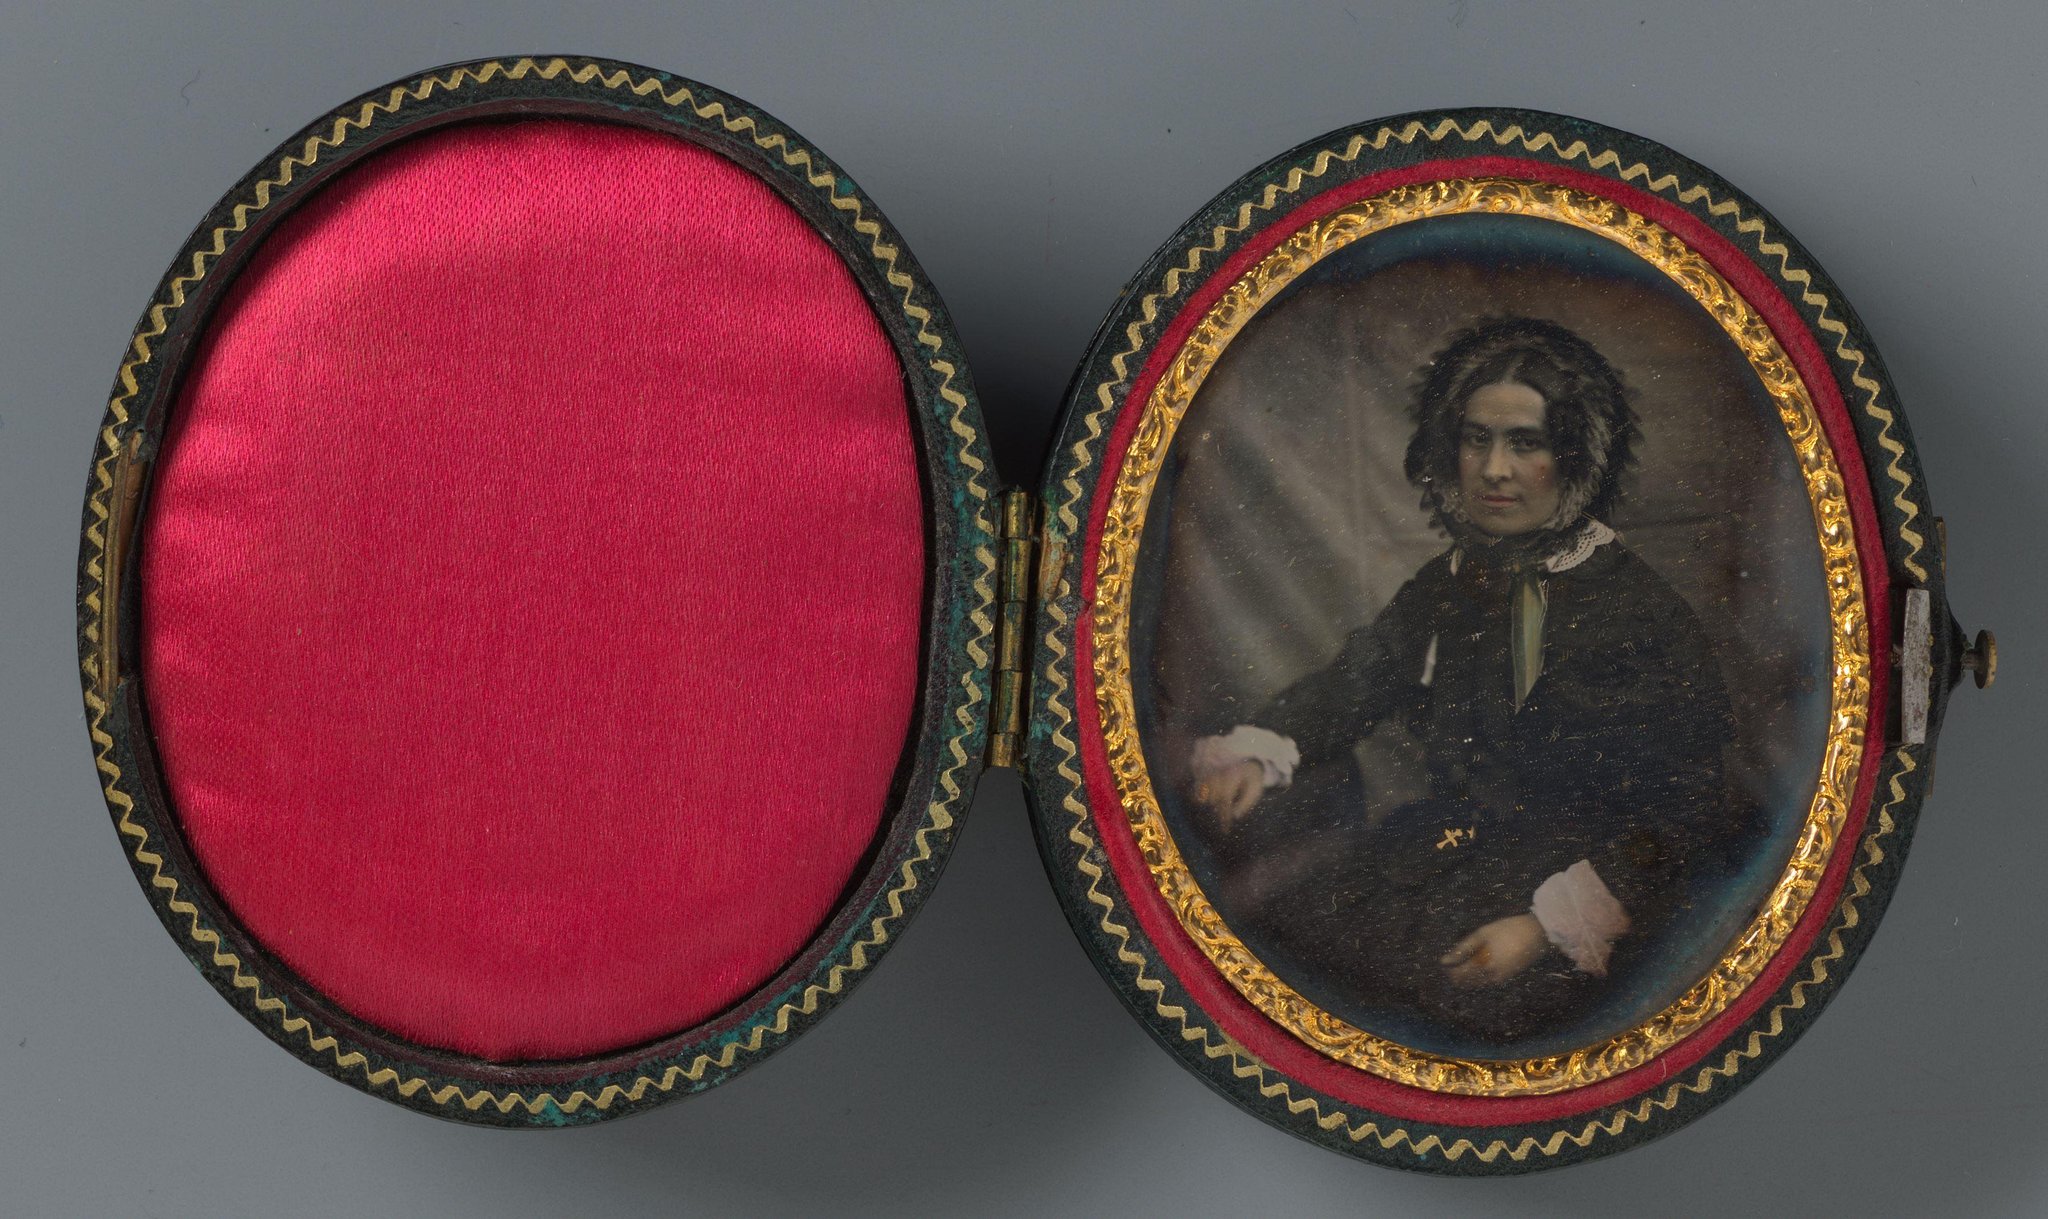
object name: photograph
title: Portret van een onbekende vrouw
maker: Anonymous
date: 1840-1860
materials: copper, glass, leather, silk, velvet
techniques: daguerreotype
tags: adult woman, historical persons